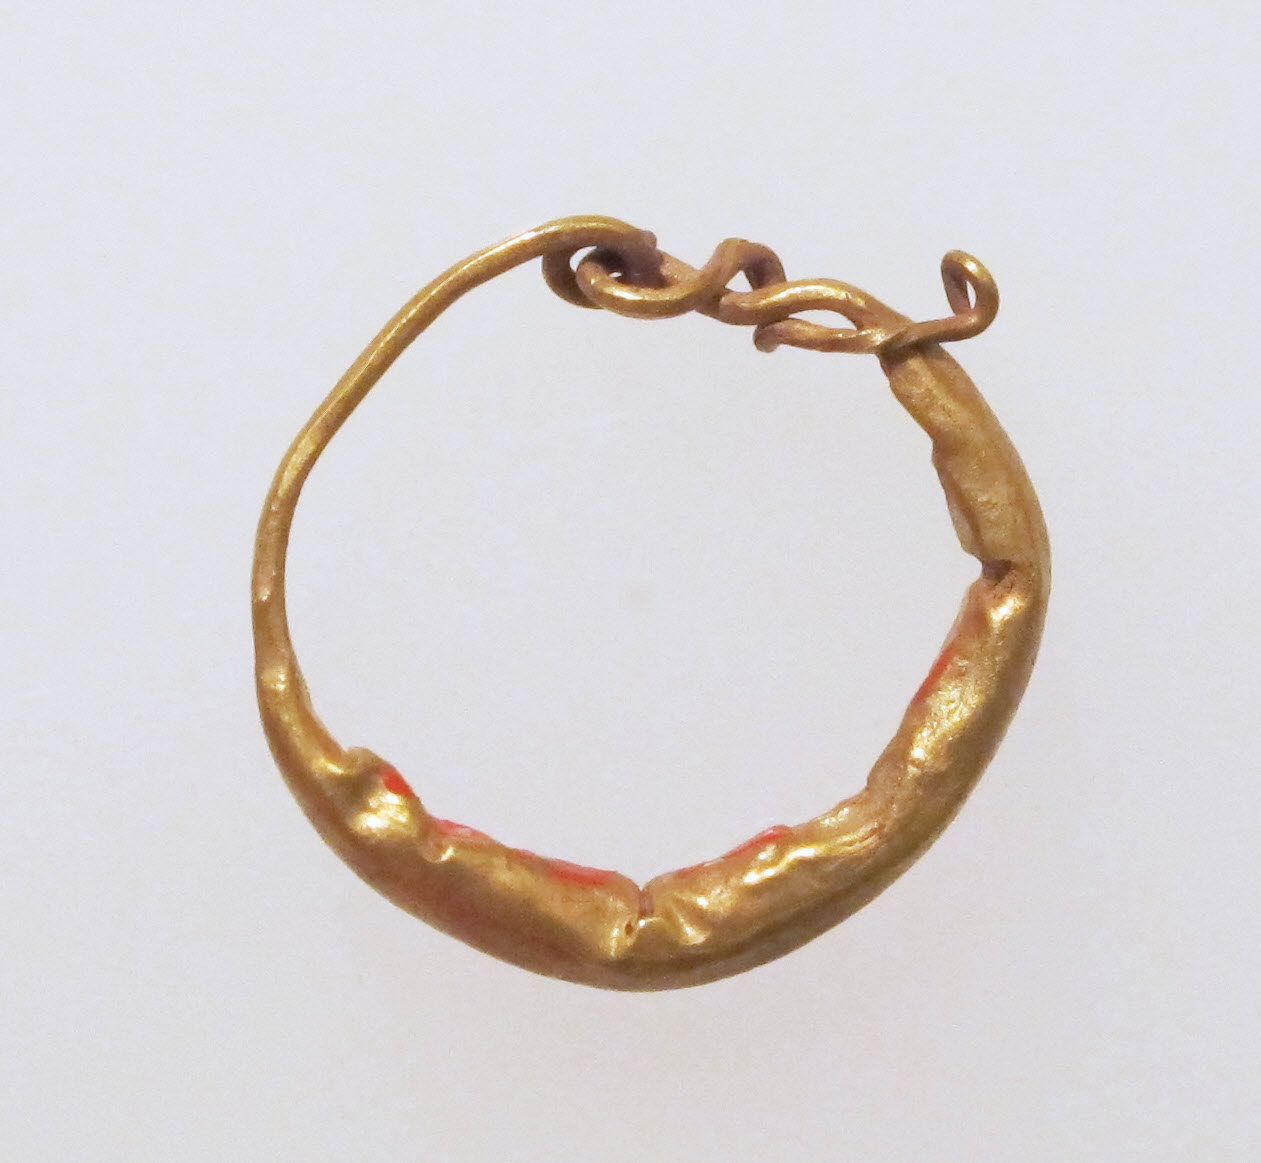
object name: earring loop type, plain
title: Earring-loop type, plain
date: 7000 BCE-330 CE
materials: gold